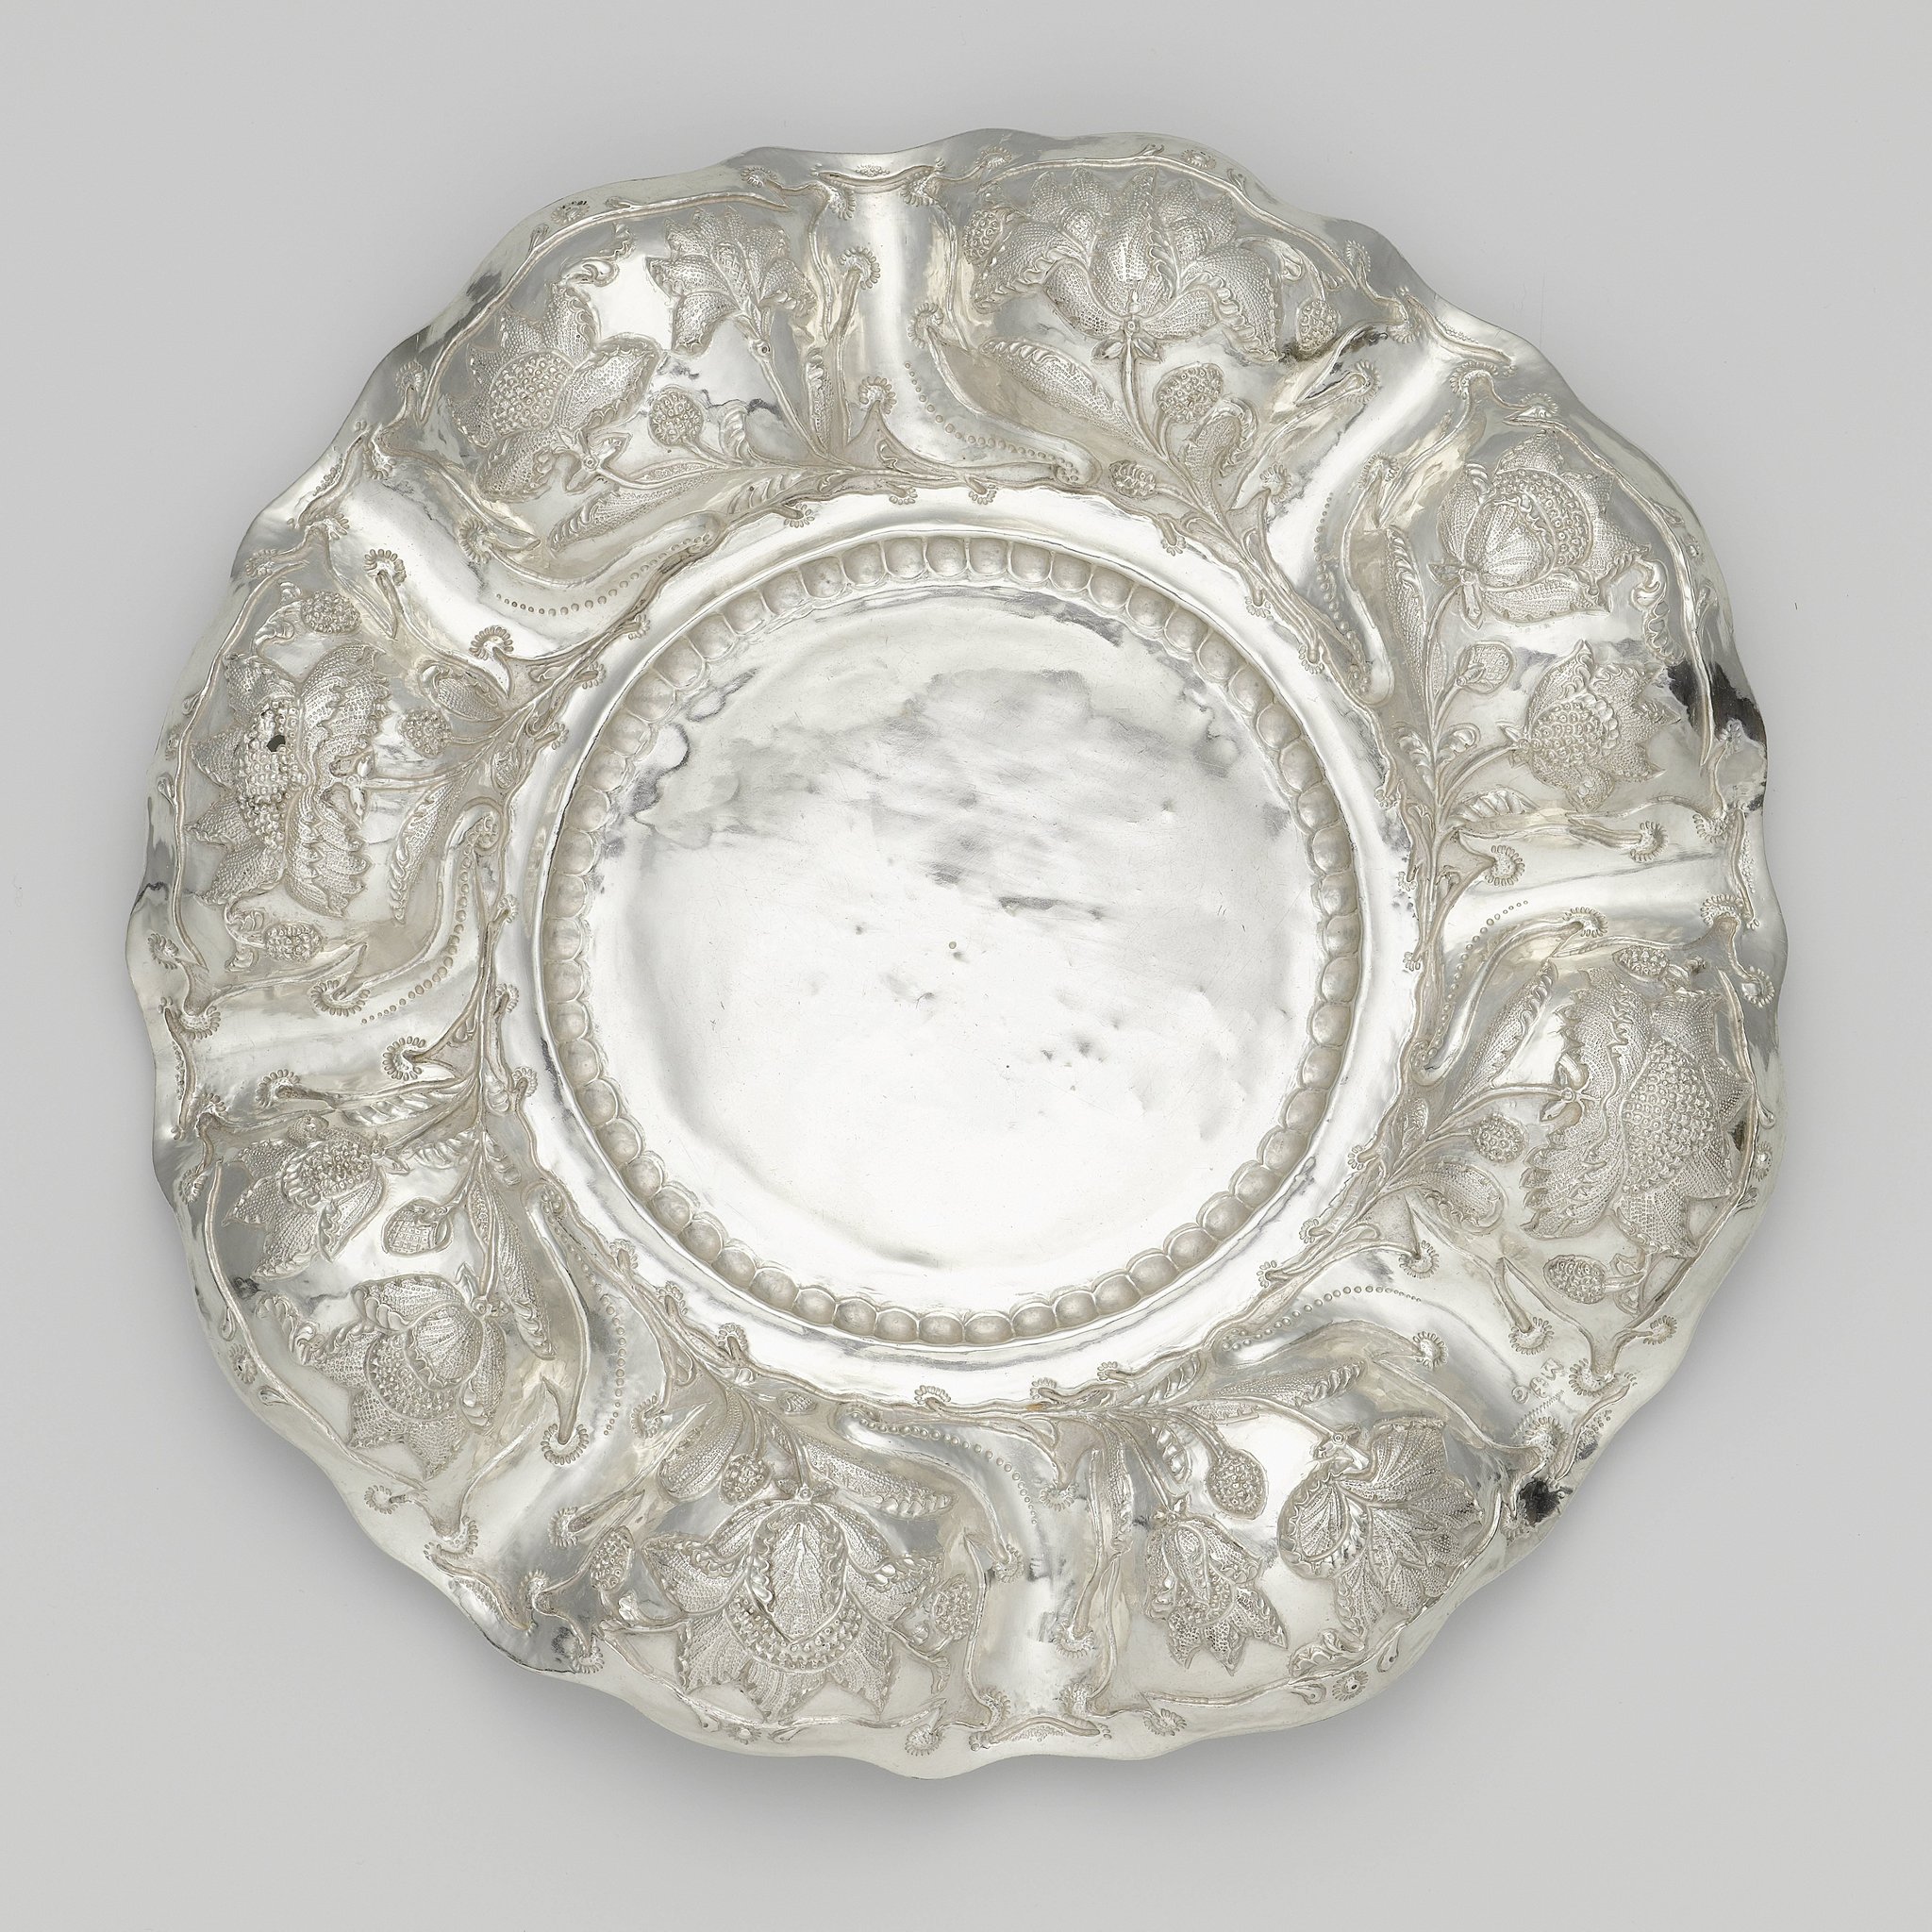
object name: platter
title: Water Bowl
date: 1679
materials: silver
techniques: metalworking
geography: batavia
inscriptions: mark: ‘G’, town mark, mark: ‘M’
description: This bowl was used for serving chilled water. It bears the silver hallmark of the Amsterdam silversmith Jacob de Grebber. In the 1670s, he travelled to Batavia (Jakarta), the centre of Dutch trade in Asia, where this bowl and dish were made. They were undoubtedly intended for Western customers; featuring large, sculptural flowers, the decoration adheres to the Dutch fashion of the time.